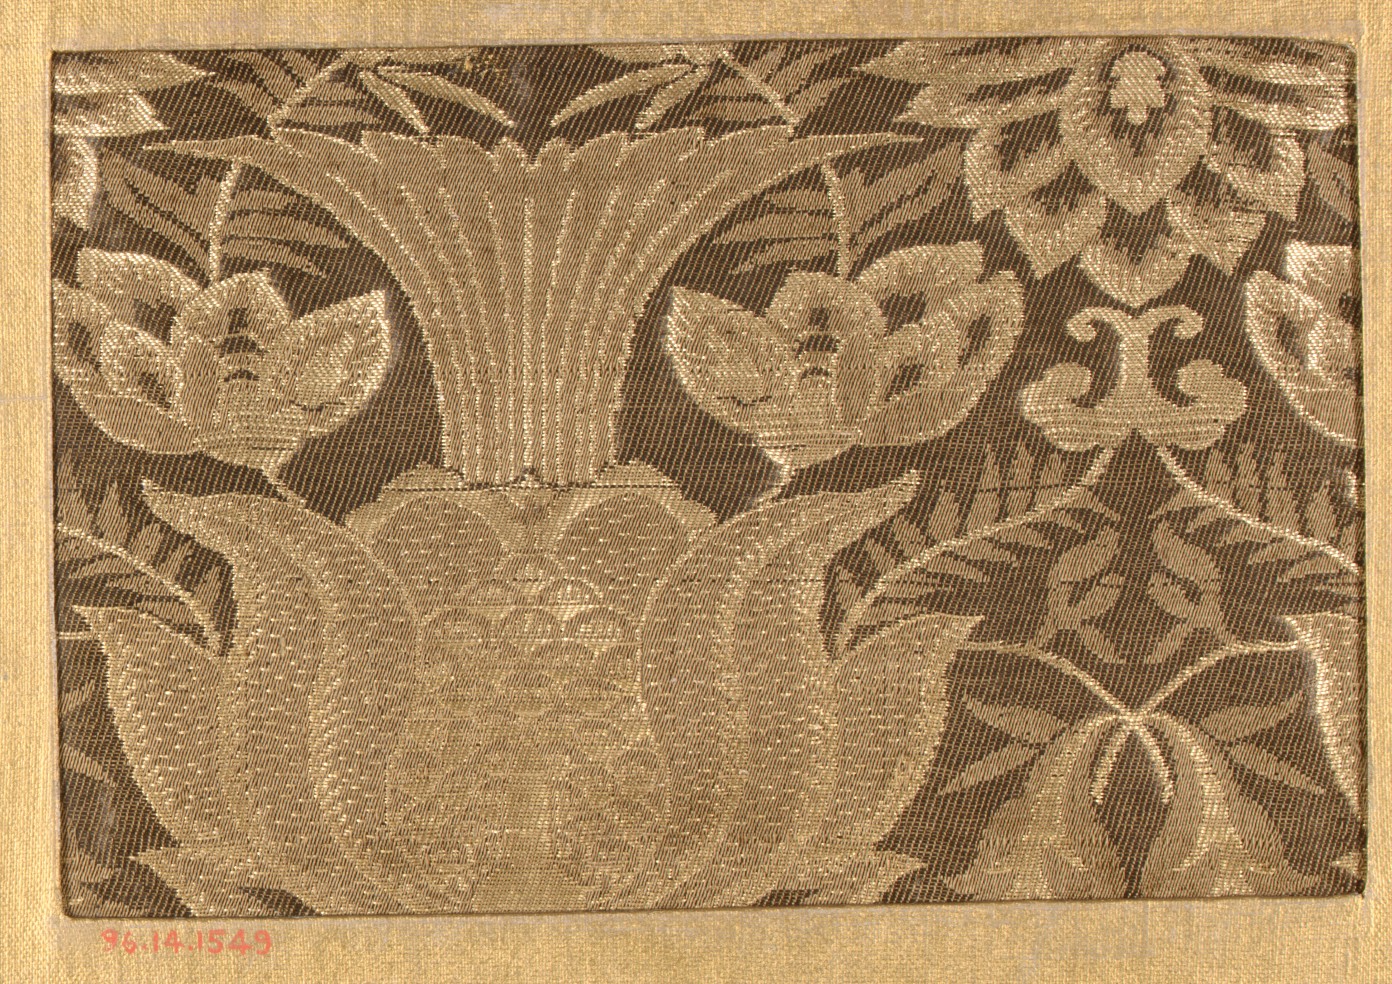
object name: piece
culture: japanese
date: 1701-1900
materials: silk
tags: leaves